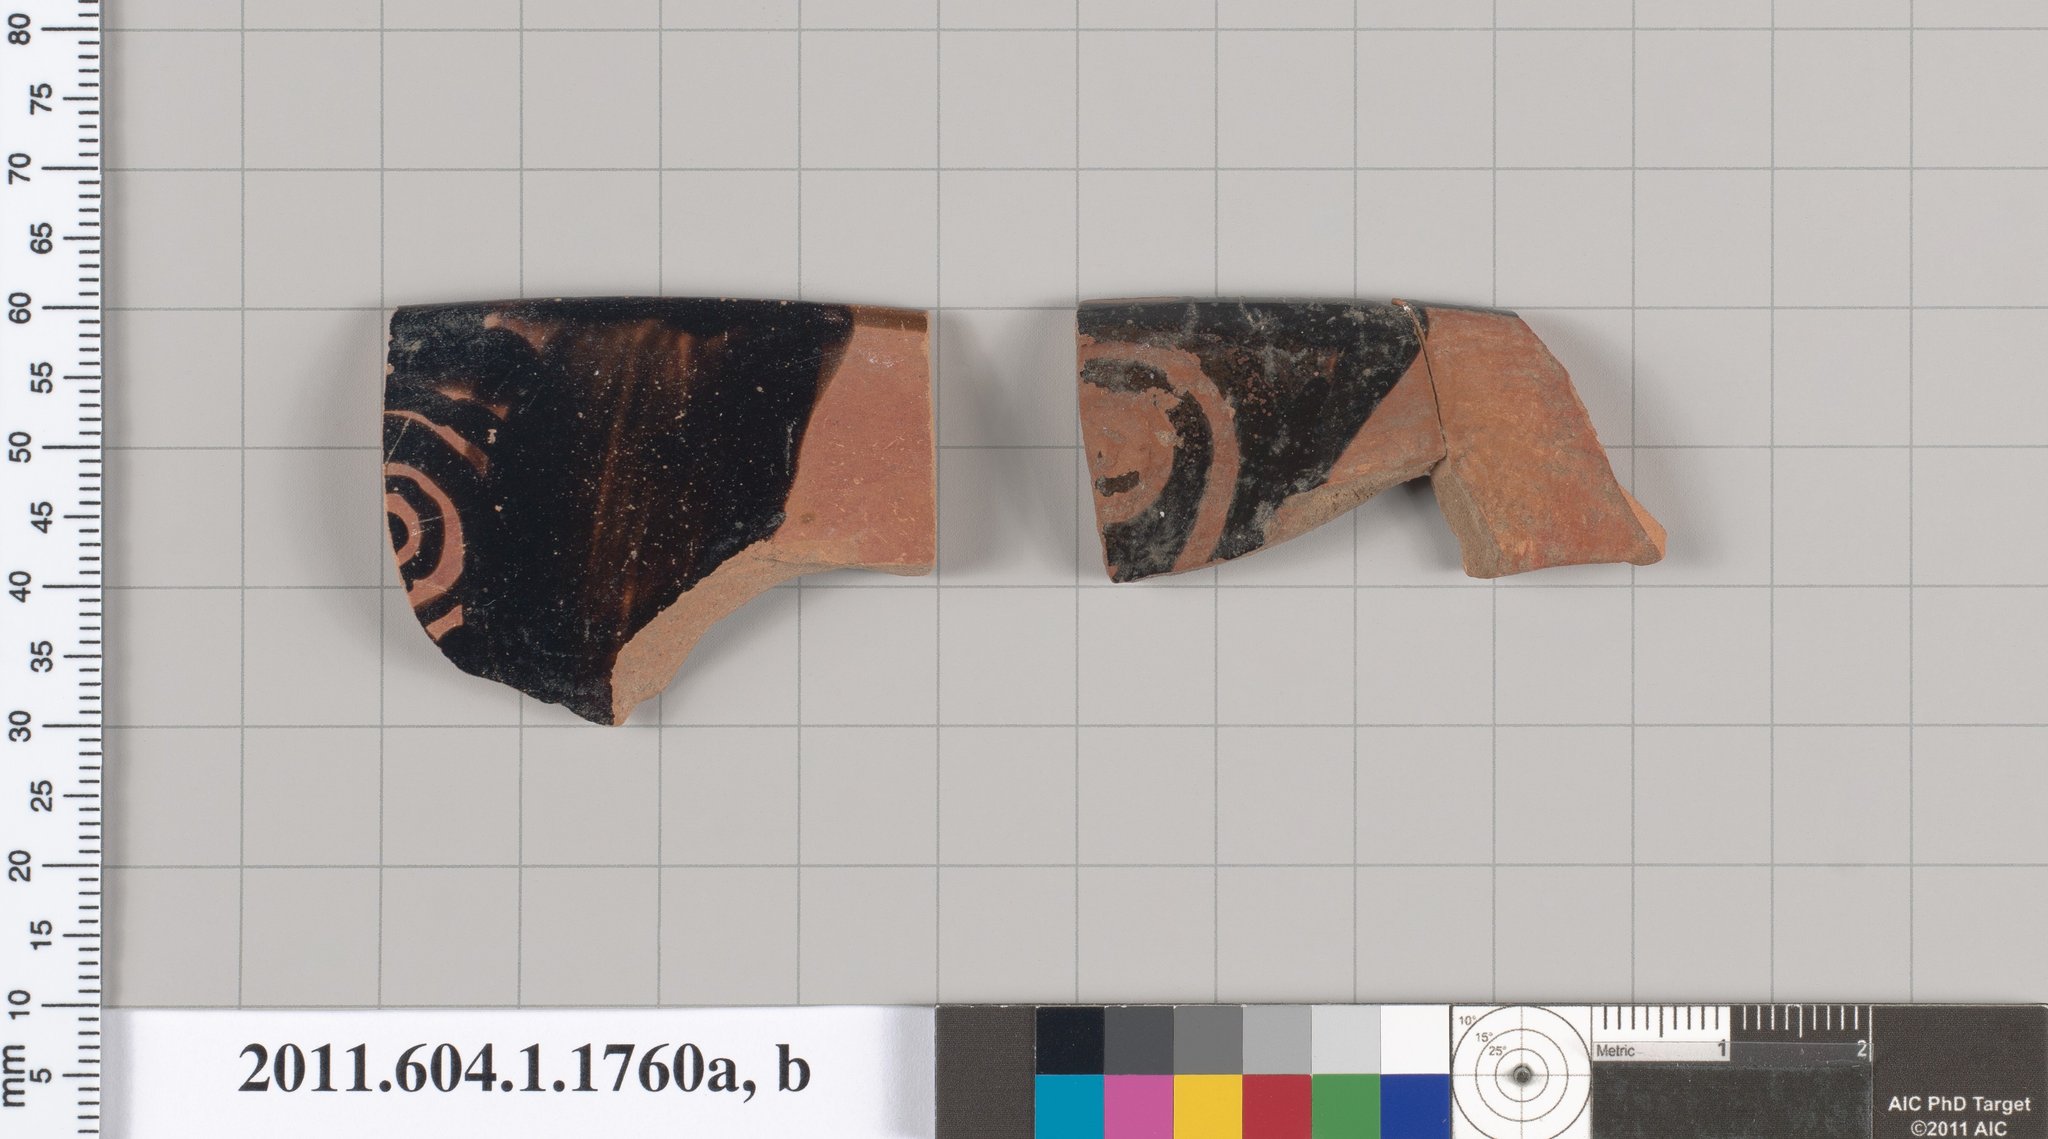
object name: kylix fragment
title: Terracotta rim fragments of kylikes(drinking cups)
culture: greek, attic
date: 467-435 BCE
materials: terracotta